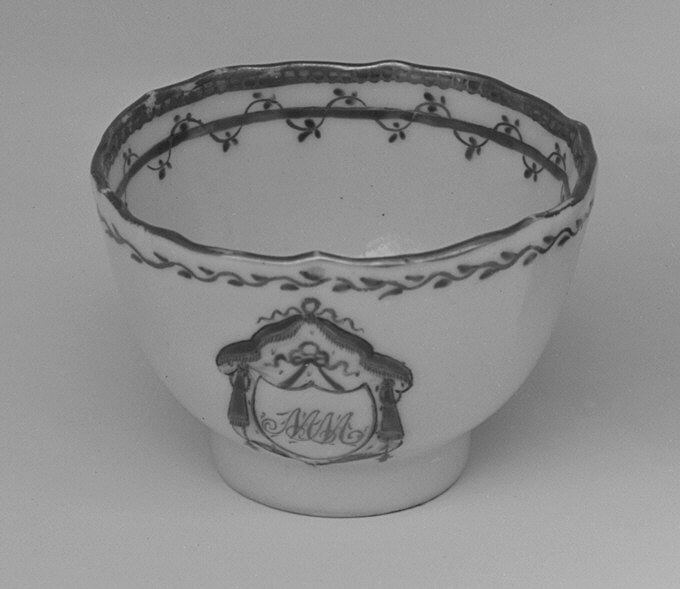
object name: teacup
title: Tea cup (part of a miniature service)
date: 1790-1800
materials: hard paste porcelain